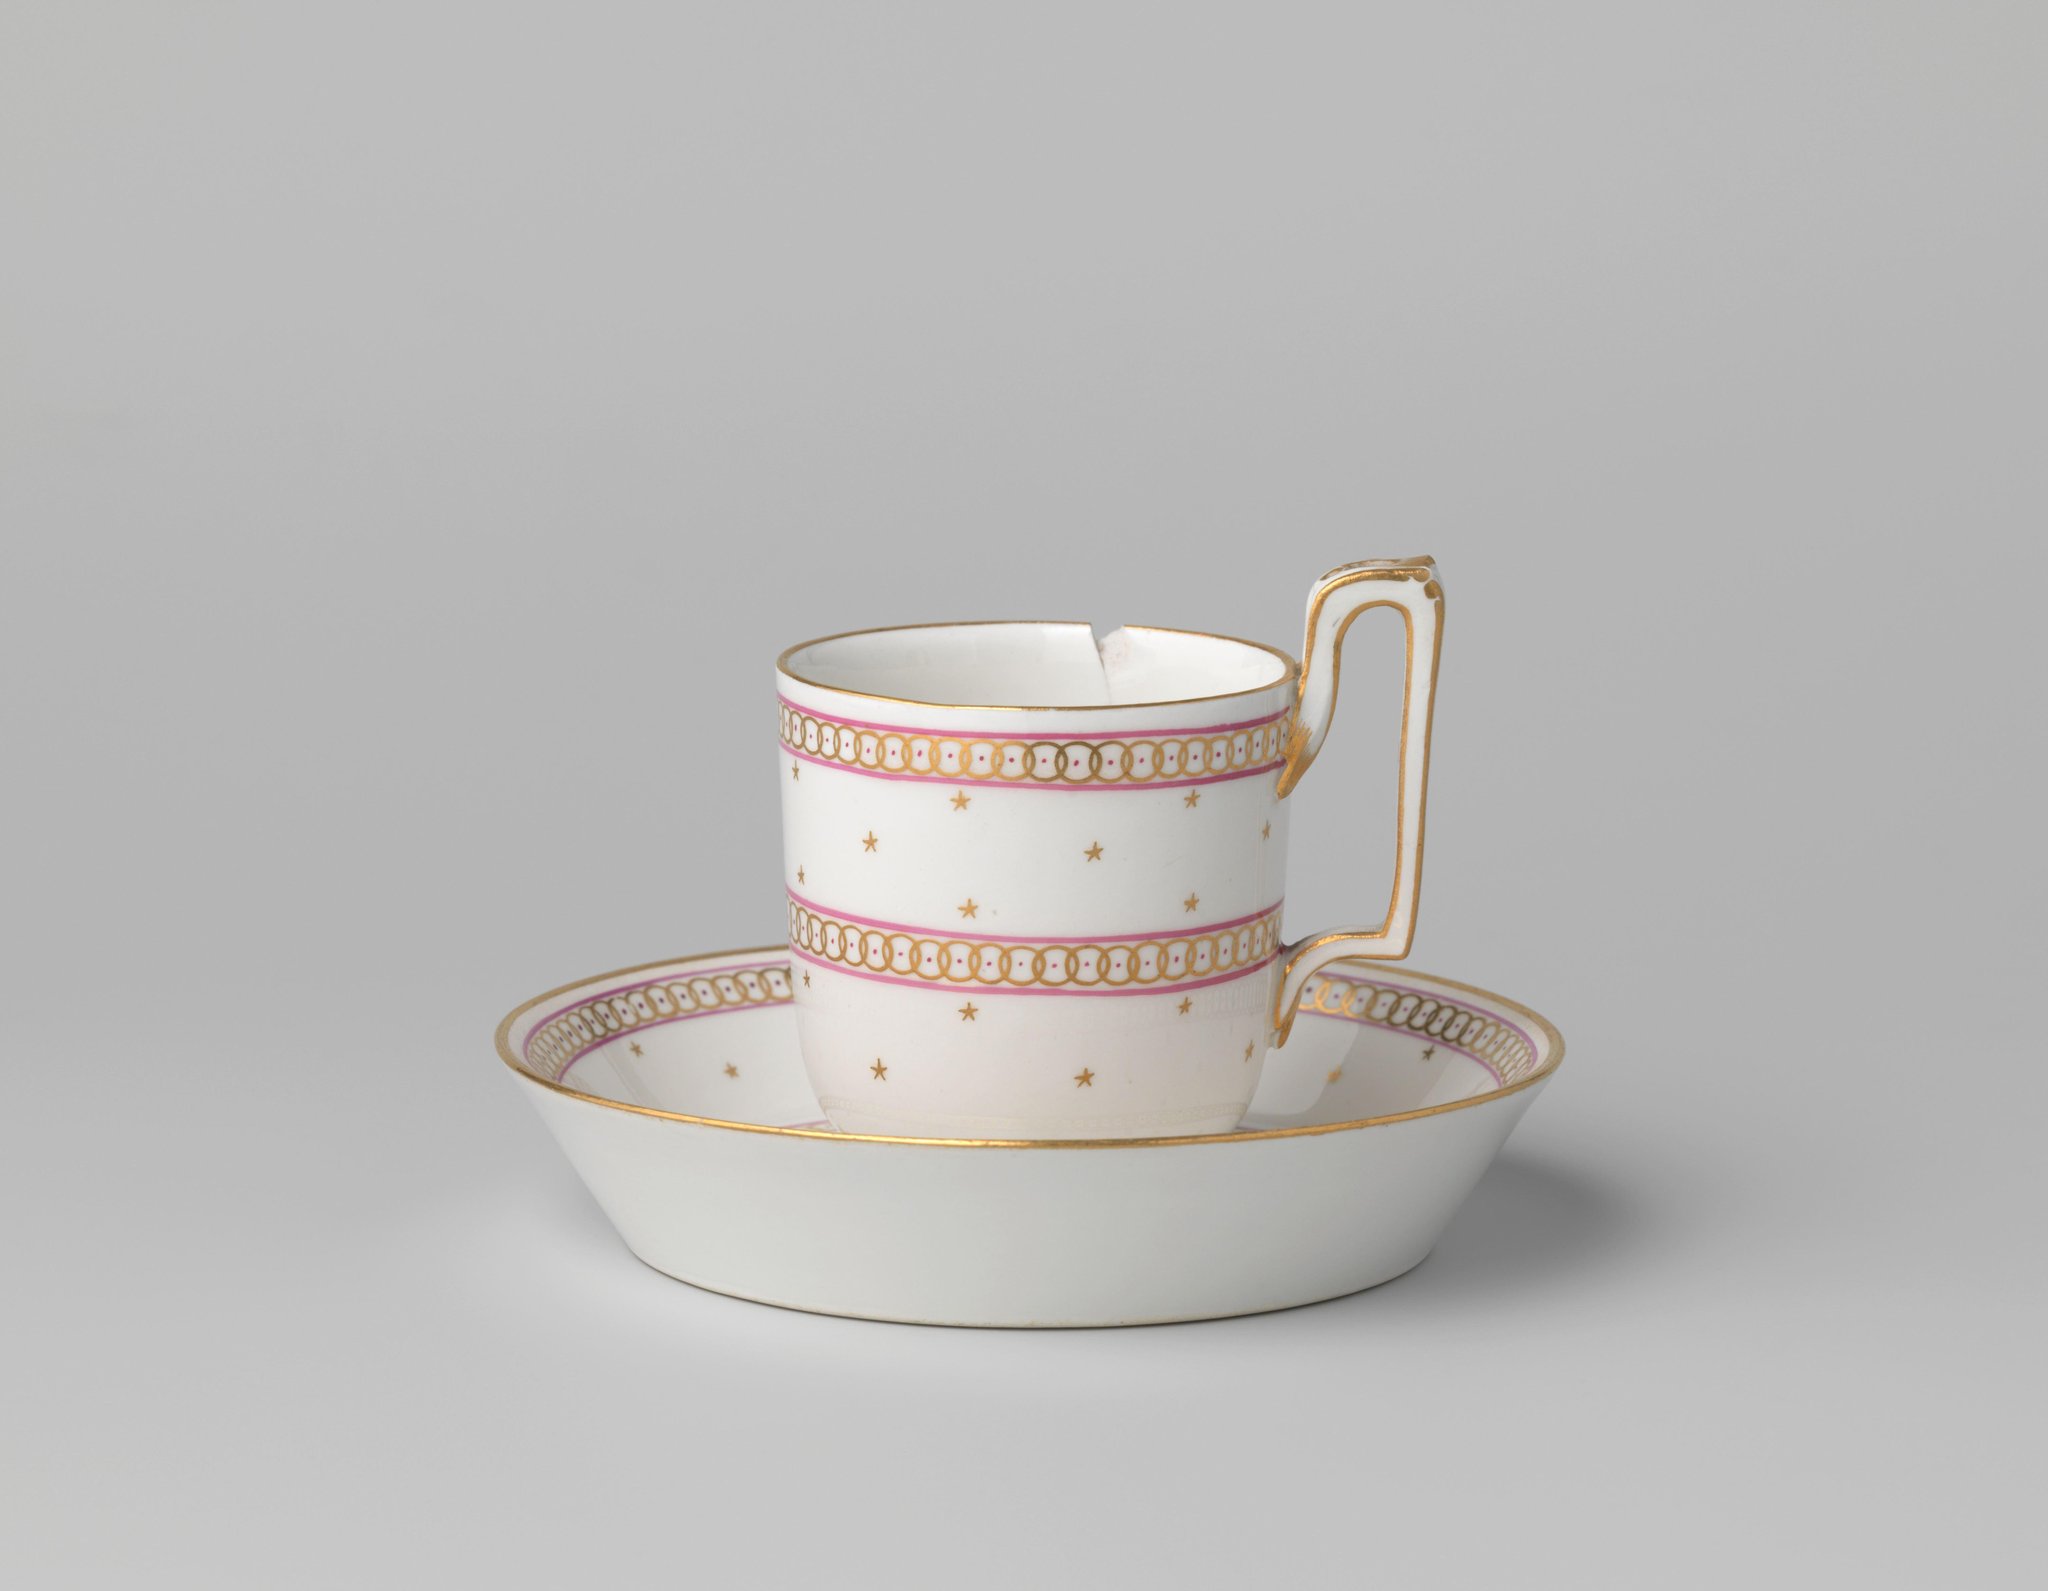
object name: kop en schotel, kop en schotel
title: Saucer with stars and ornamental borders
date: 1791-1801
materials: glaze, gold, paint, porcelain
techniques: firing, forming, gilding, turning, vitrification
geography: vienna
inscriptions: mark: ‘schild/ 101/ 39/ 91’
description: Delen van een cilindervormig koffieservies bestaande uit een kan (A) en 6 koppen en schotels (B t/m G) beschilderd in paars en goud met sterretjes en kettingen. Gemerkt met een fabrieksmerk in onderglazuurblauw en ingegrift 801 26 (kan), 791 33 (koppen) 791 39 (schotels).